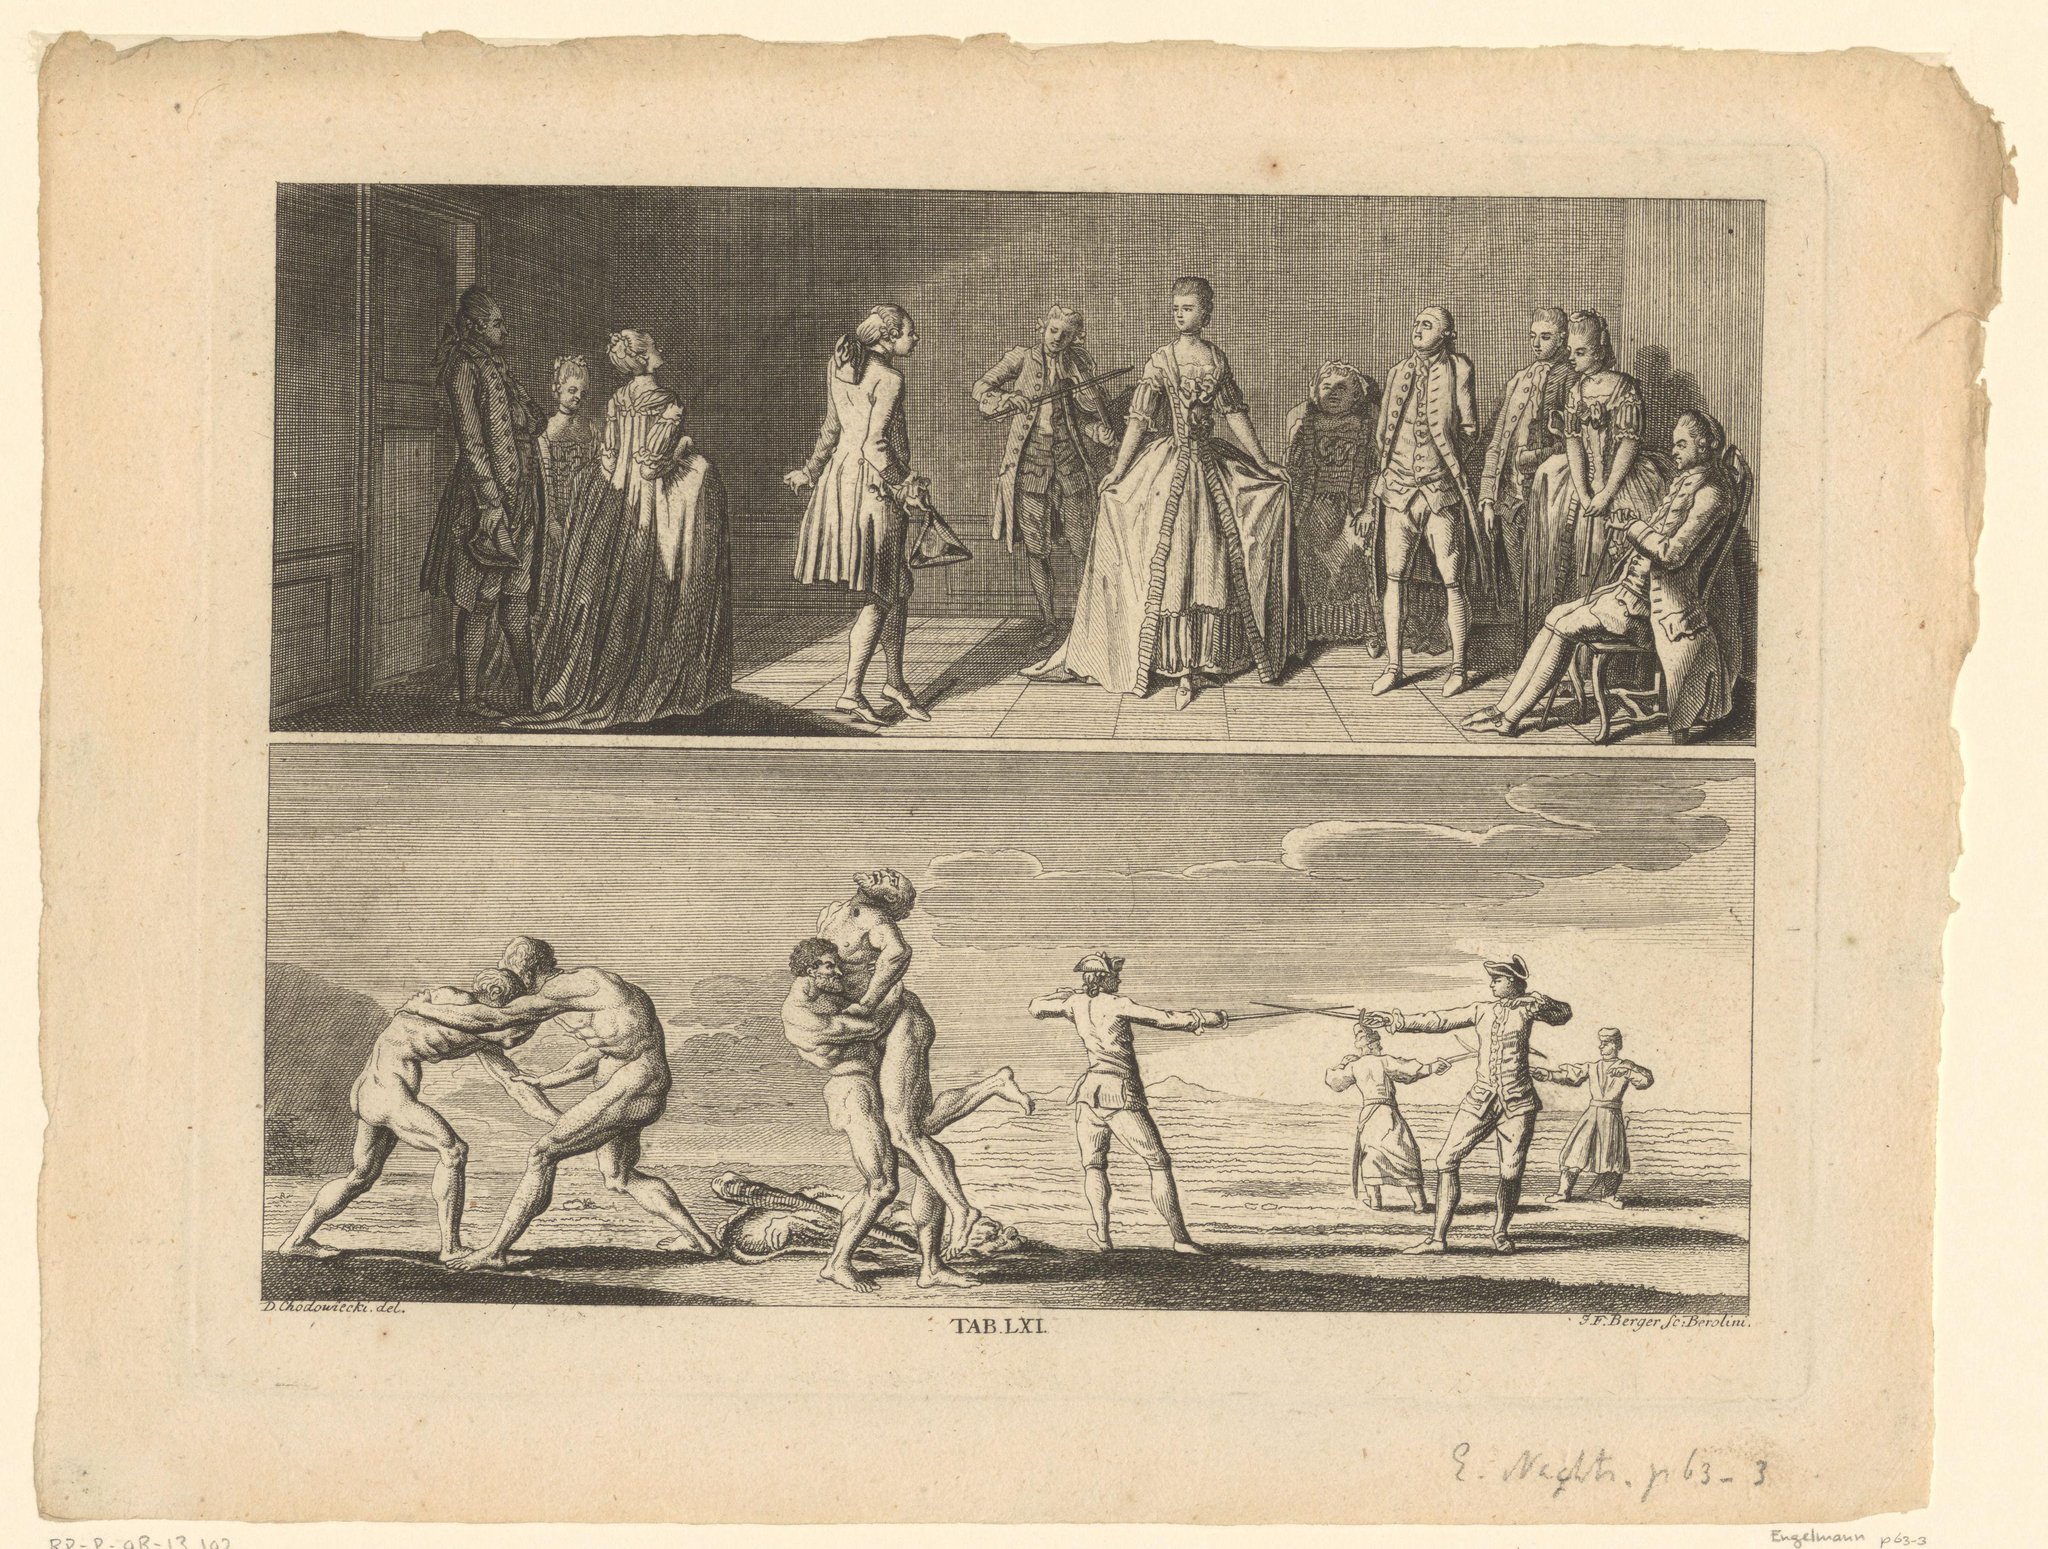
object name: book illustration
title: Dansende en schermende mensen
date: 1774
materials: paper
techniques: etching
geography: berlin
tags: violin, fiddle, one pair dancing; man and woman dancing as a couple, wrestling (sport), fencing (sport)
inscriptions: collector's mark: Lugt 2228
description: Boven een man en een vrouw dansend op de muziek van een viool, gadegeslagen door een gezelschap. Onder een landschap met worstelende en schermende mannen. Middenonder genummerd: Tab. LXI.